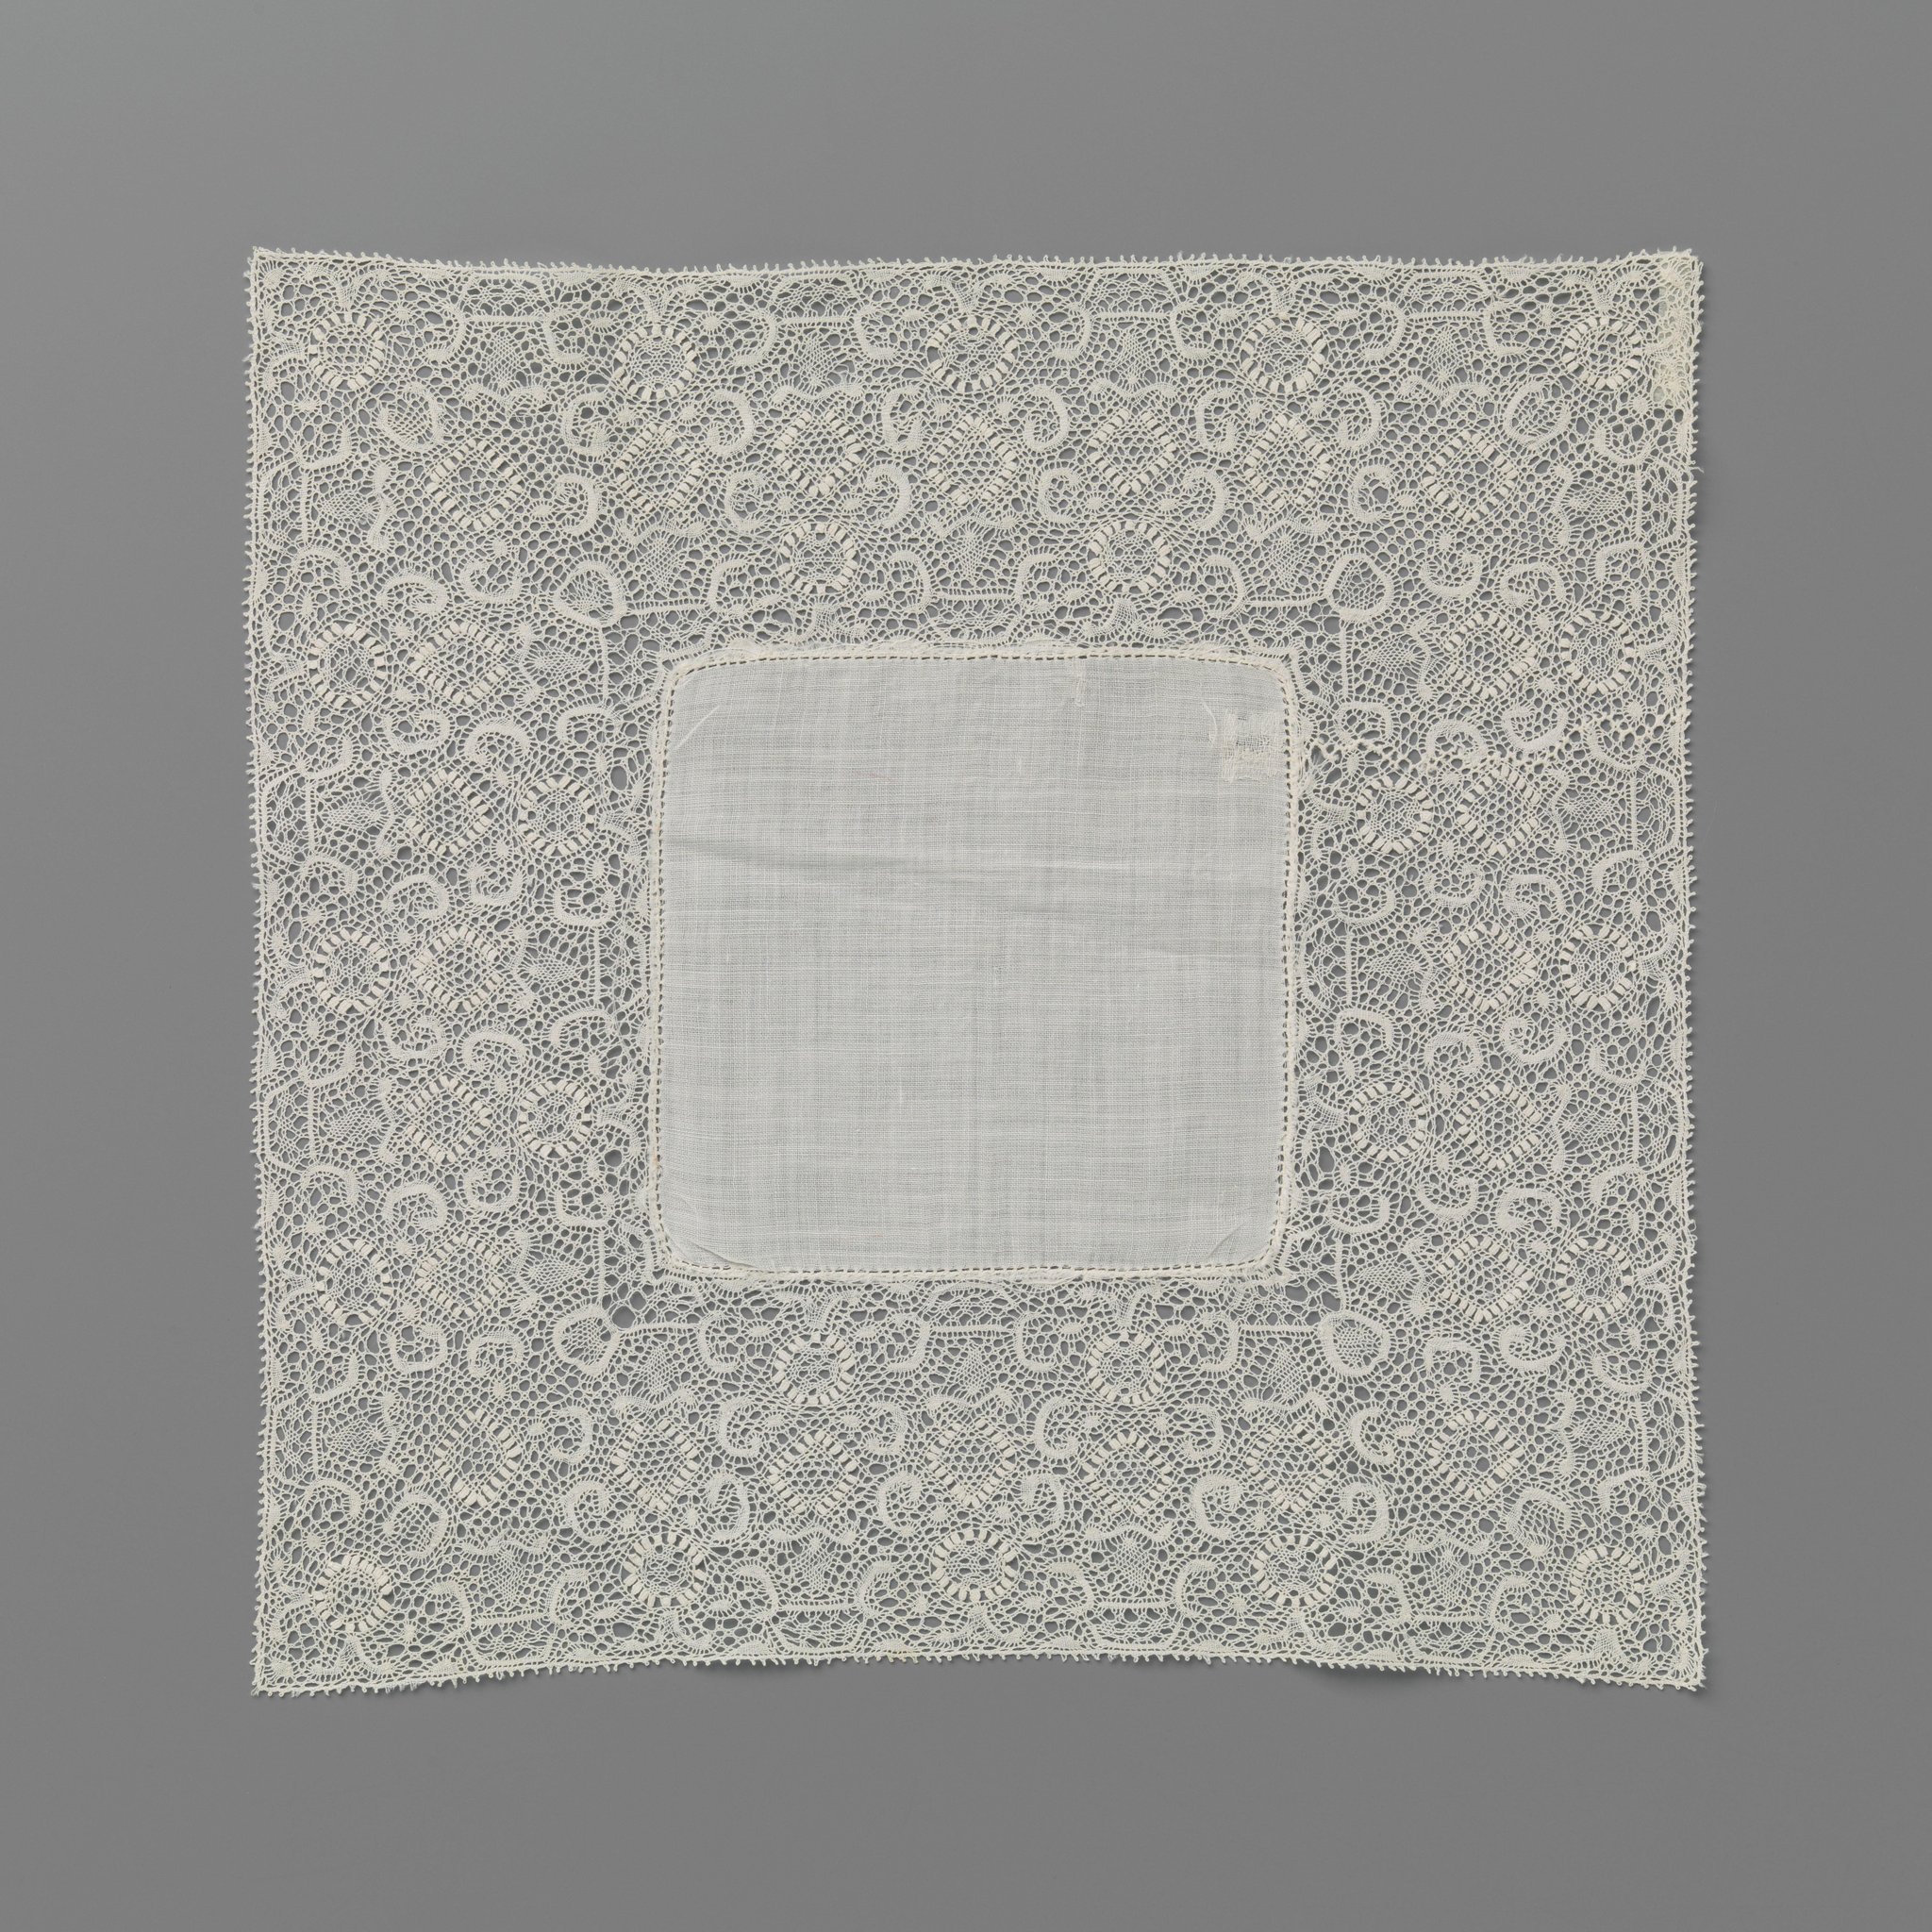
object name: handkerchief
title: Zakdoek van kloskant met c-voluten waartussen een ruitvormige bloem in een pot en een rond boompje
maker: Anonymous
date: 1830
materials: textile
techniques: lace, weave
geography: southern netherlands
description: Zakdoek van naturelkleurige batist afgezet met een brede rand kloskant: toveressenkant. Vierkant model met rechte zijden die zijn afgewerkt met picots. Het patroon bestaat uit een lijnenspel van c-voluten met geringde sneeuwvlokken, waartussen een ruitvormige bloem in een pot en een rond boompje boven elkaar staan. In de hoeken staat een iets afwijkend maar vergelijkbaar patroon dat schuin geplaatst is. De motieven zijn gemaakt in linnenslag en netslag en ze zijn onder andere met elkaar verbonden door een getwijnde kruisslagengrond. Opvallend zijn de vormslagen waarmee de contouren van de ruitvormen en cirkels zijn gemaakt.